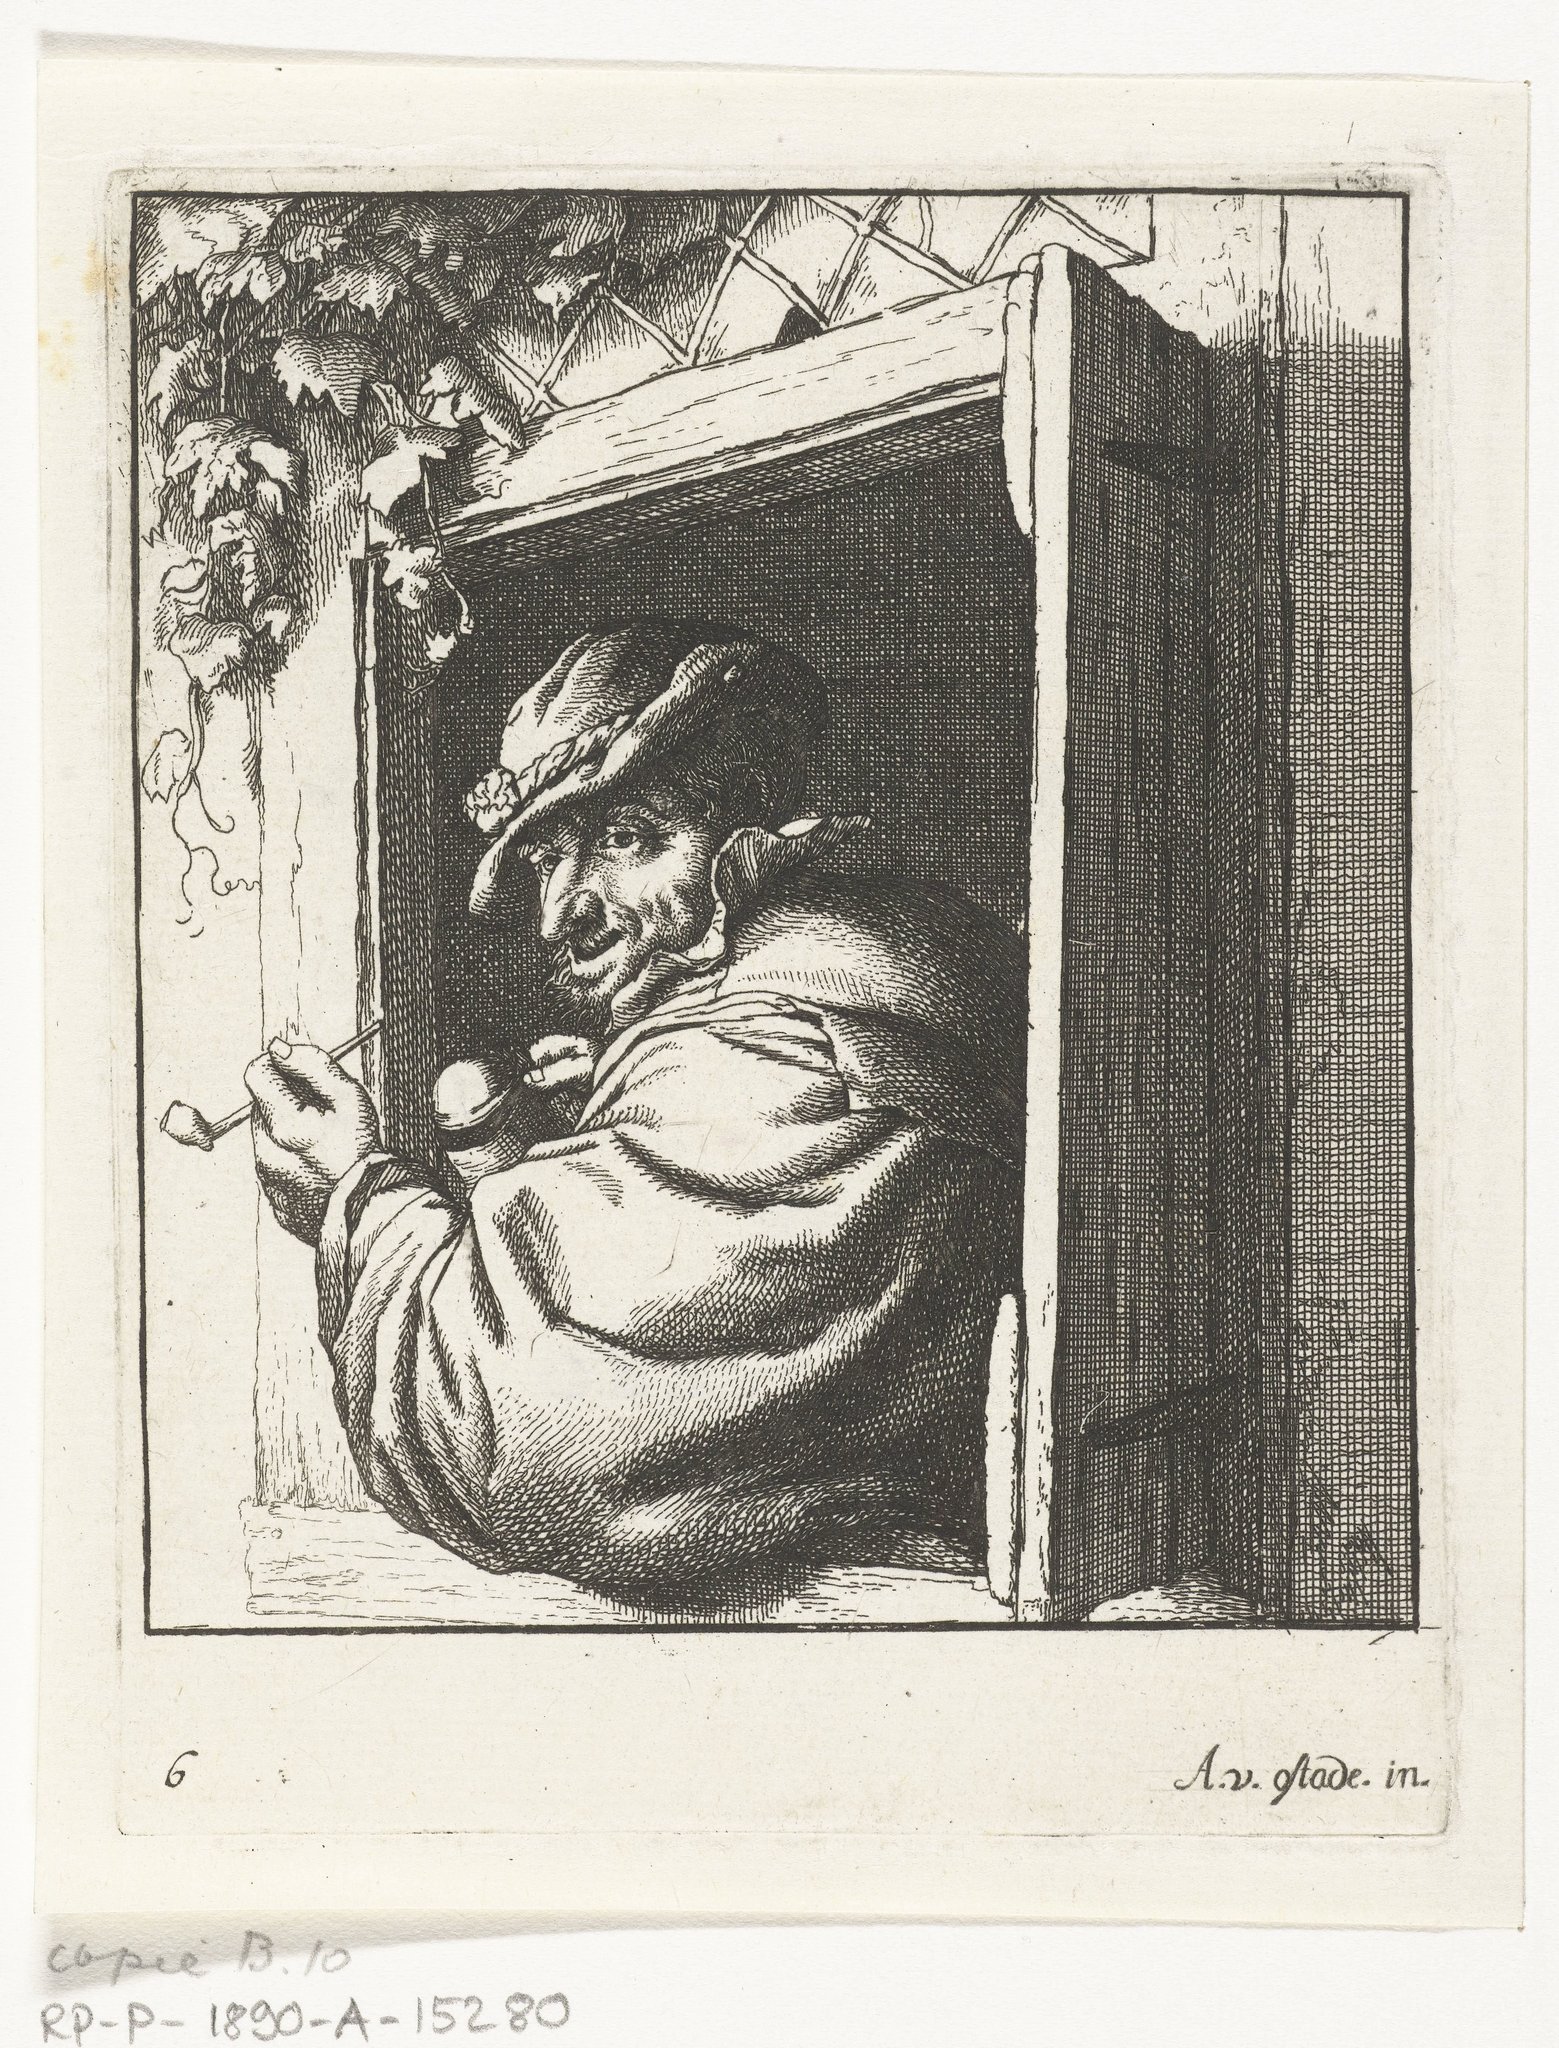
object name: print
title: Caprice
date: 1655-1690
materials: paper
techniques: etching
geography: amsterdam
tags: window, pipe ~ tobacco, male sex; man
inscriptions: collector's mark: Lugt 2228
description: Boer of man met pijp en drinkbeker in een raamopening met een naar buiten openslaand luik. Prent uit een serie van acht prenten naar voorstellingen van A. van Ostade.